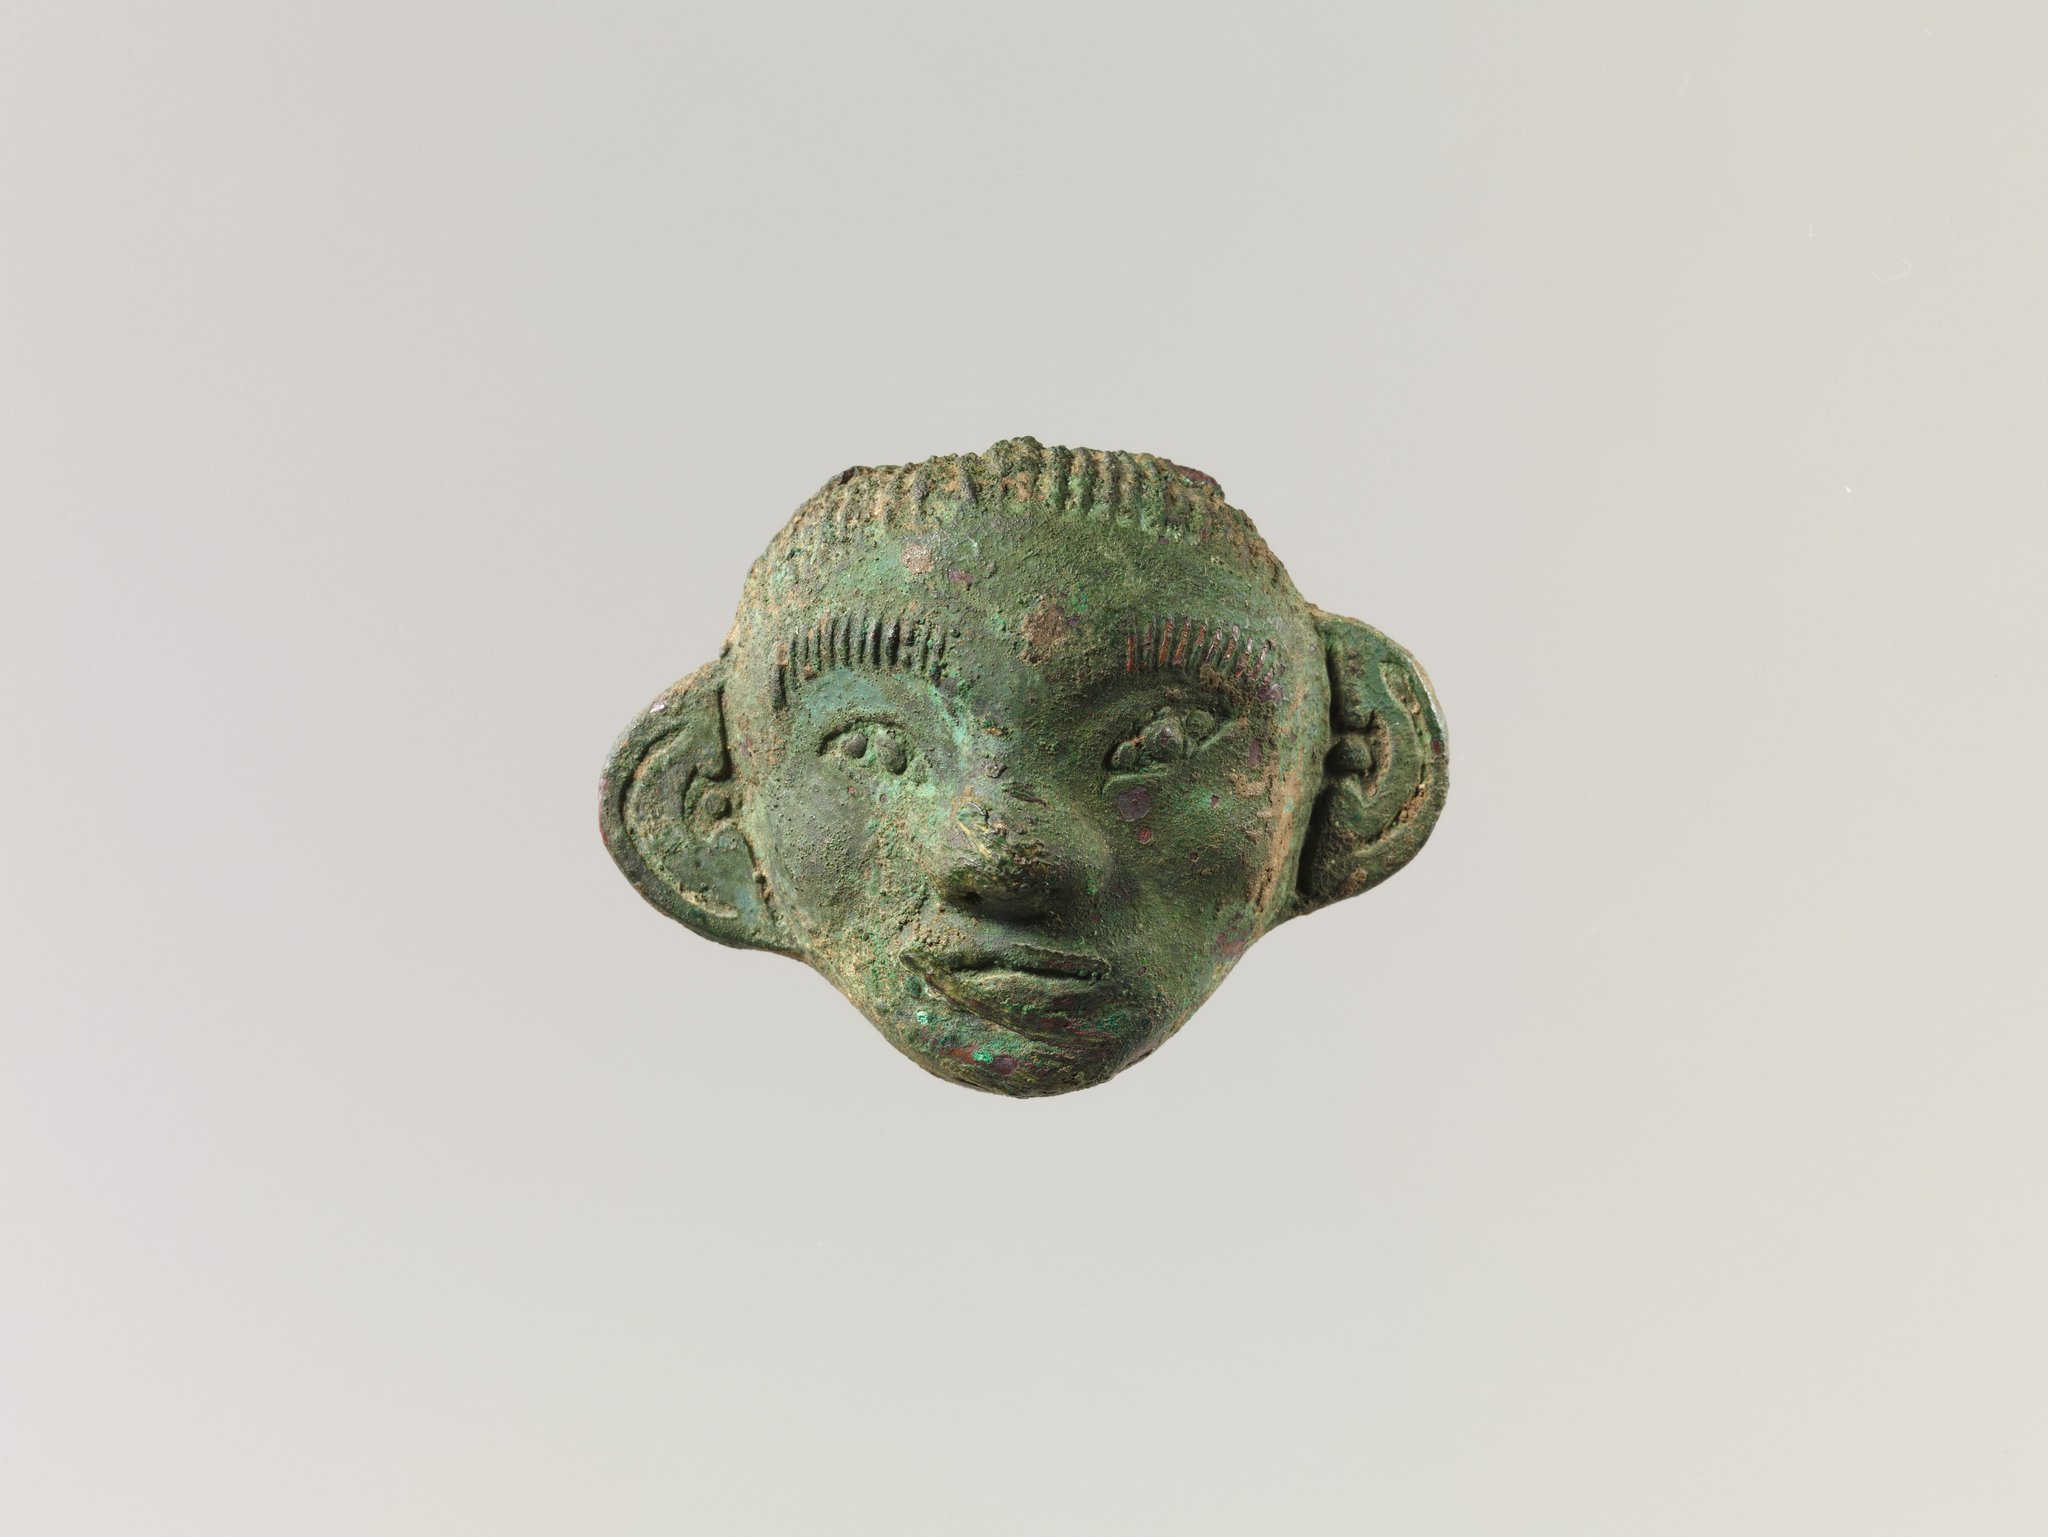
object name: mount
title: Mounting in Form of a Human Mask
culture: chinese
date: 1046-256 BCE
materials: bronze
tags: masks